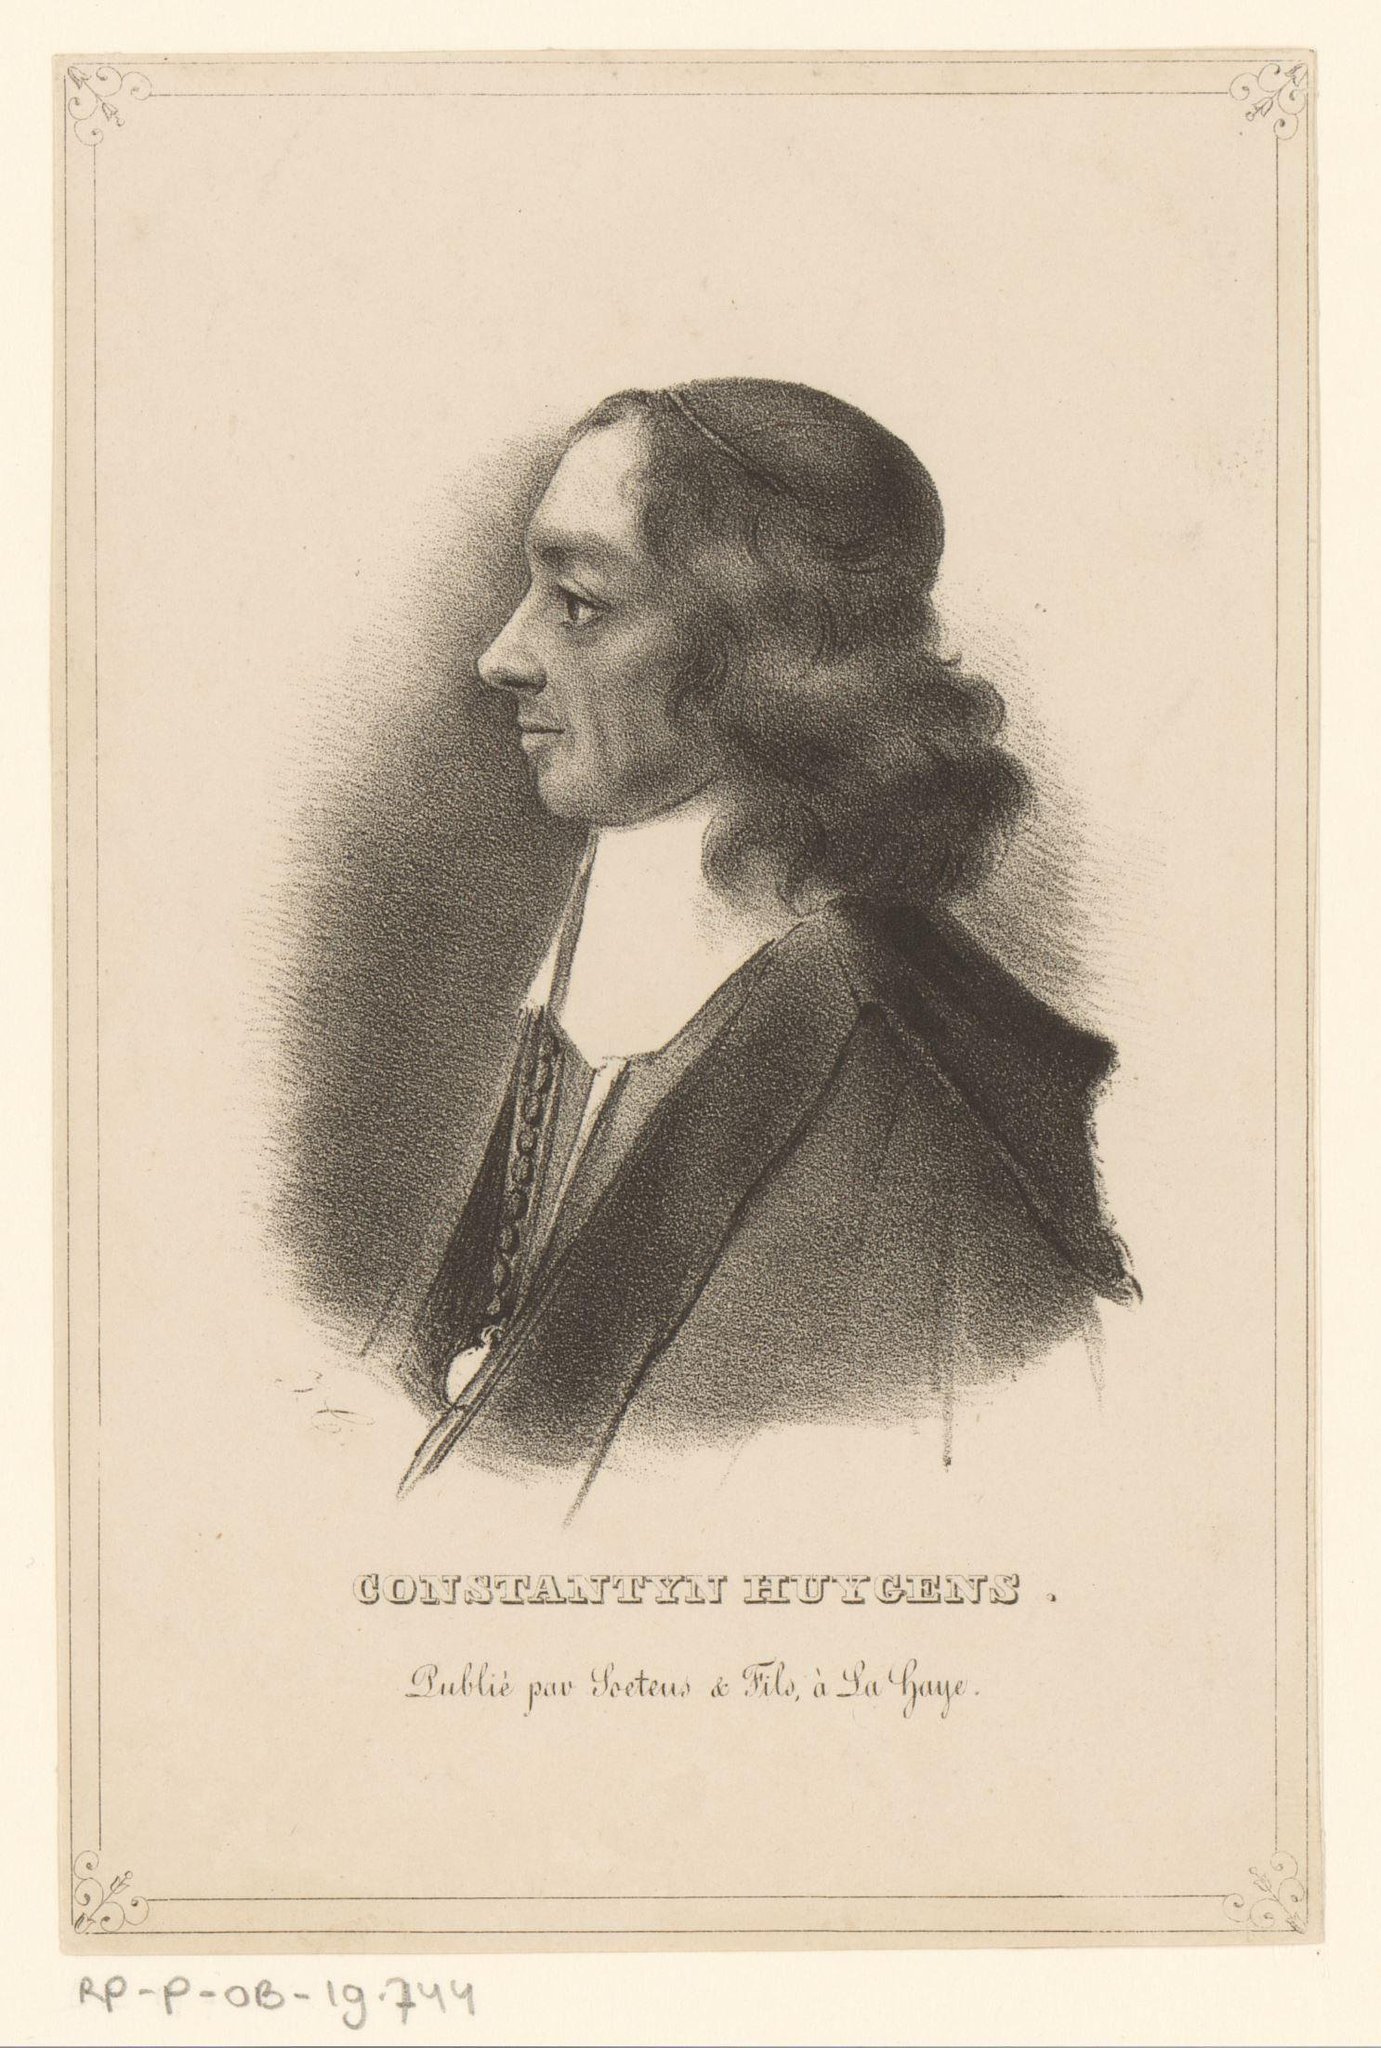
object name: print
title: Portret van Constantijn Huygens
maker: j.b. clermans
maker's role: print maker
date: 1837-1840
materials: paper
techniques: lithograph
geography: the hague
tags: the hague, constantijn huygens (i), historical persons (+ (full) bust portrait)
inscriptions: monogram: ‘JC’, collector's mark: Lugt 2228